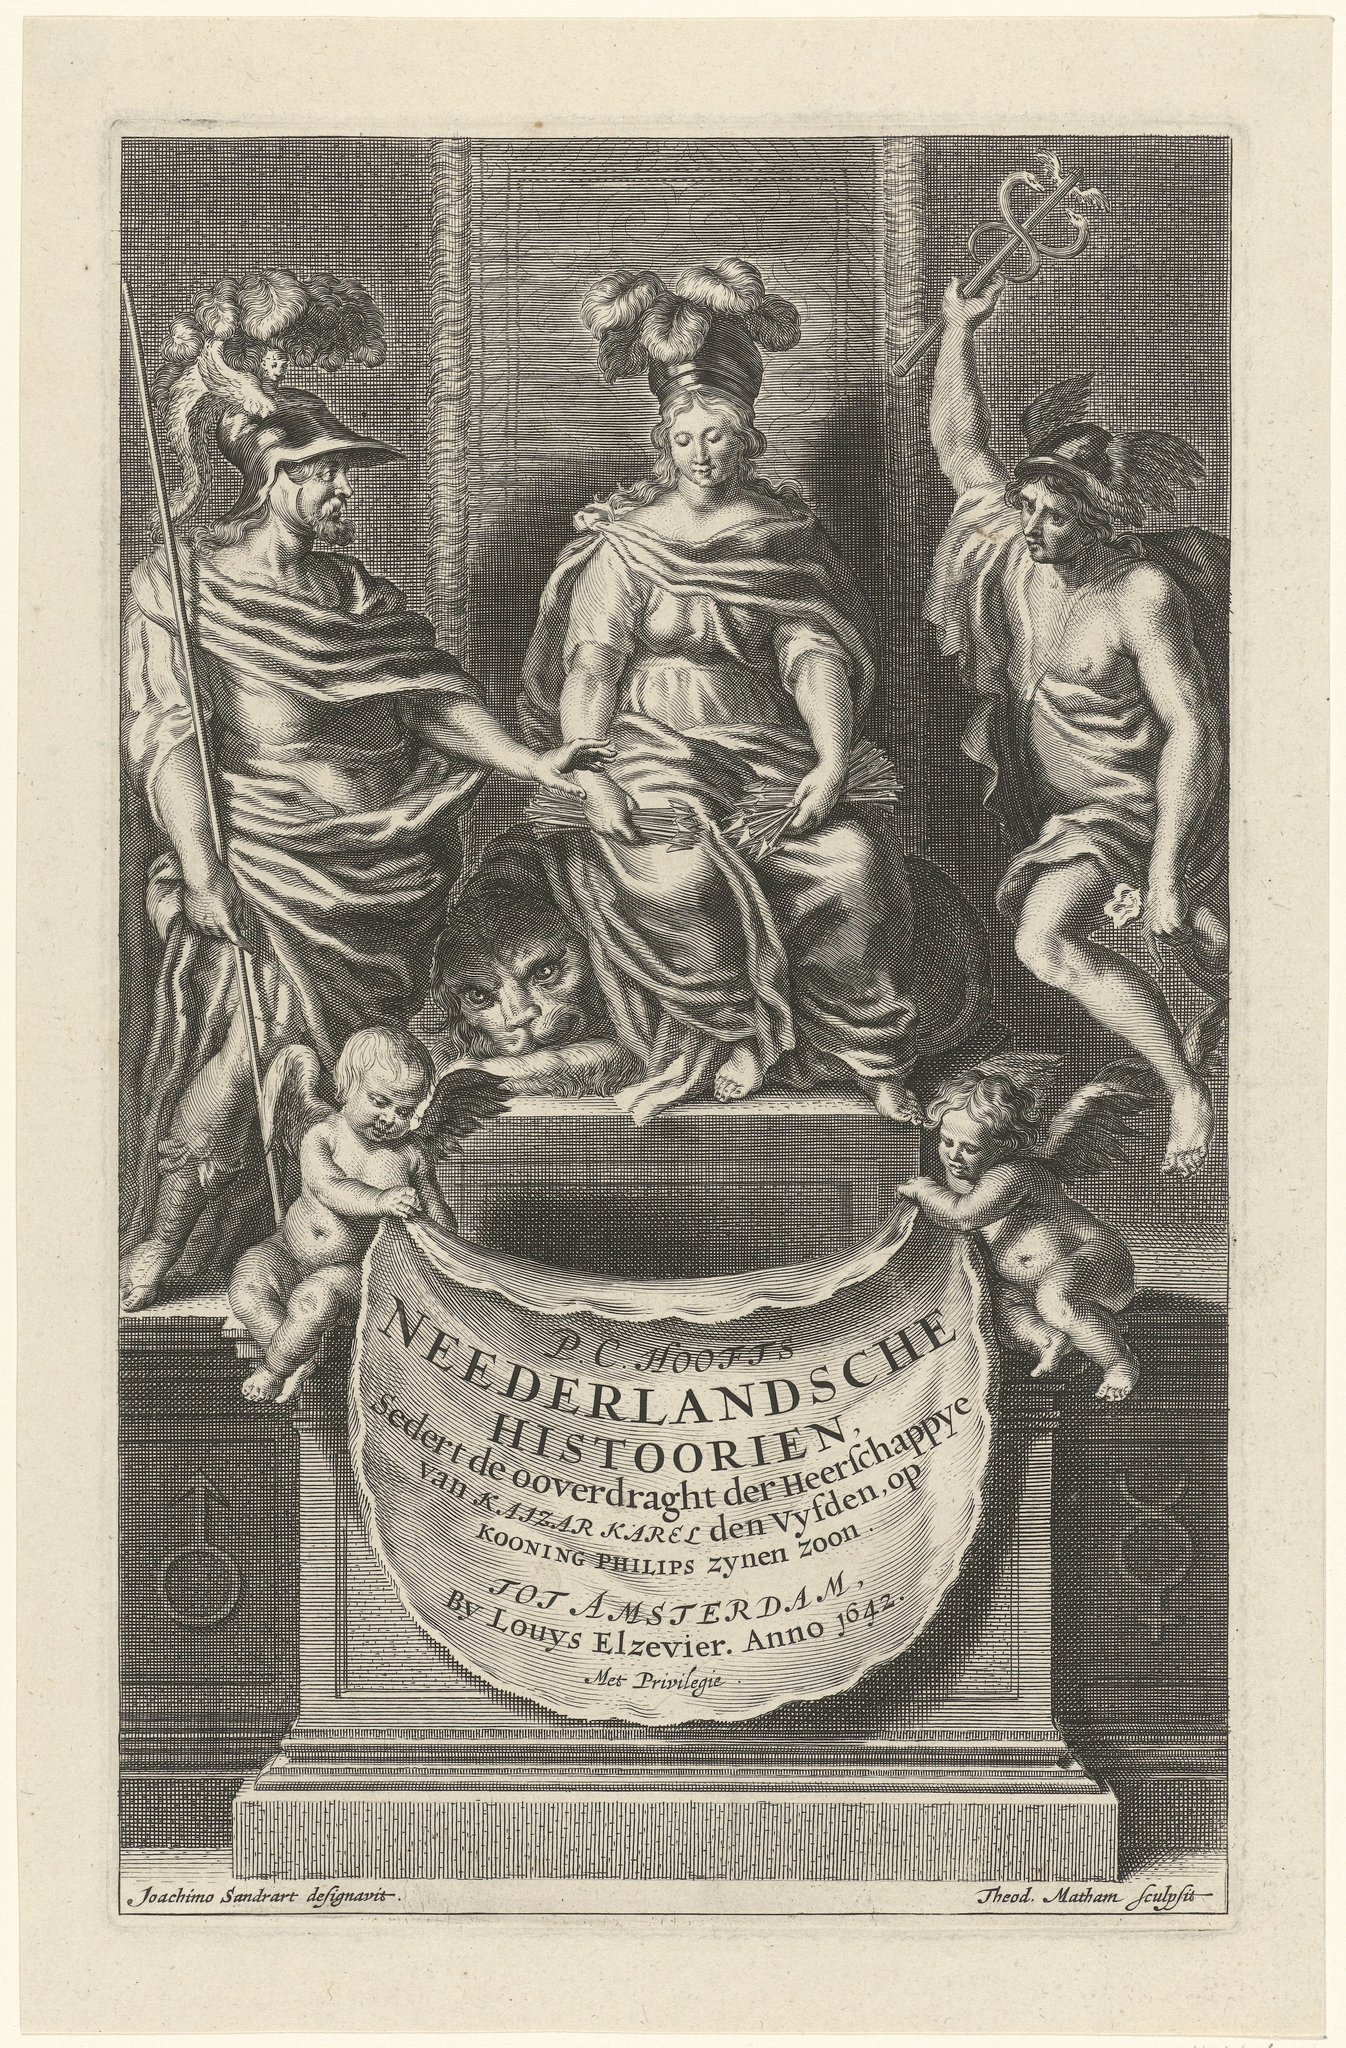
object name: print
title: Mars en Mercurius bij de Hollandse maagd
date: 1642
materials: paper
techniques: engraving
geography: amsterdam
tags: (story of) mars (ares), (story of) mercury (hermes), cupids: 'amores', 'amoretti', 'putti', symbols of particular nations, states, districts, etc.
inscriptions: collector's mark: Lugt 240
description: Mars en Mercurius bij de Hollandse maagd, zittend op een leeuw, op een sokkel. Voor de sokkel houden twee putti een vellum op, waarop de titel.